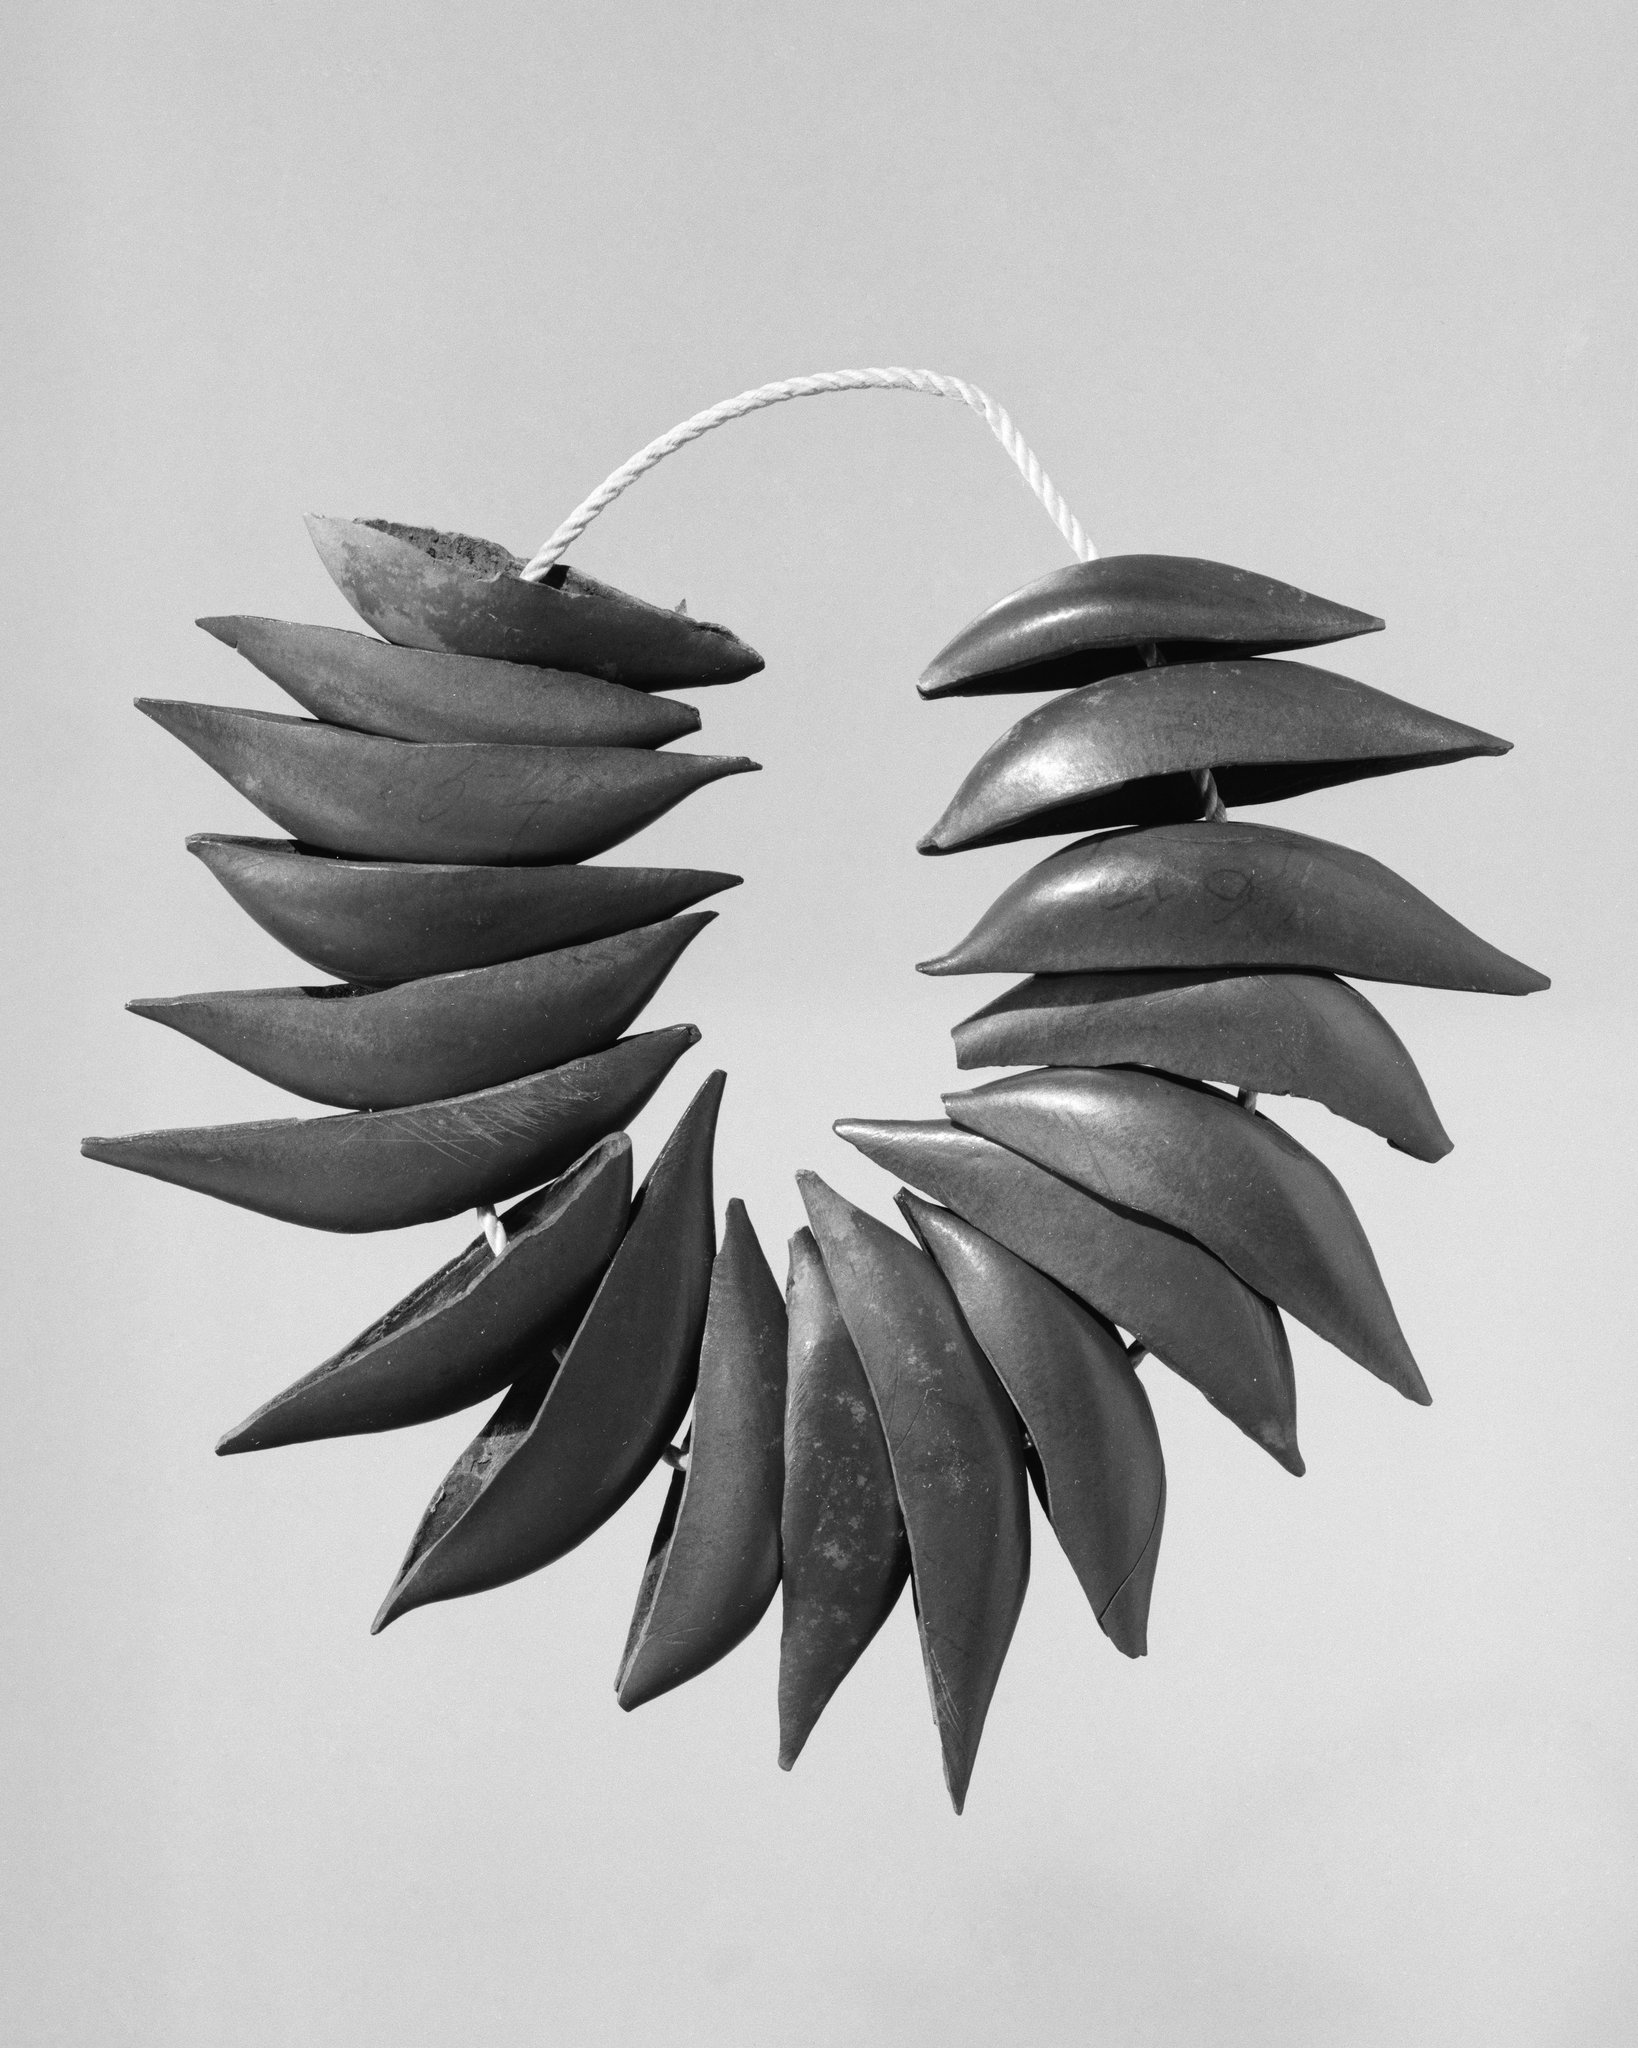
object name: seed rattle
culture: papua new guinean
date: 1867-1900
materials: cord, shell